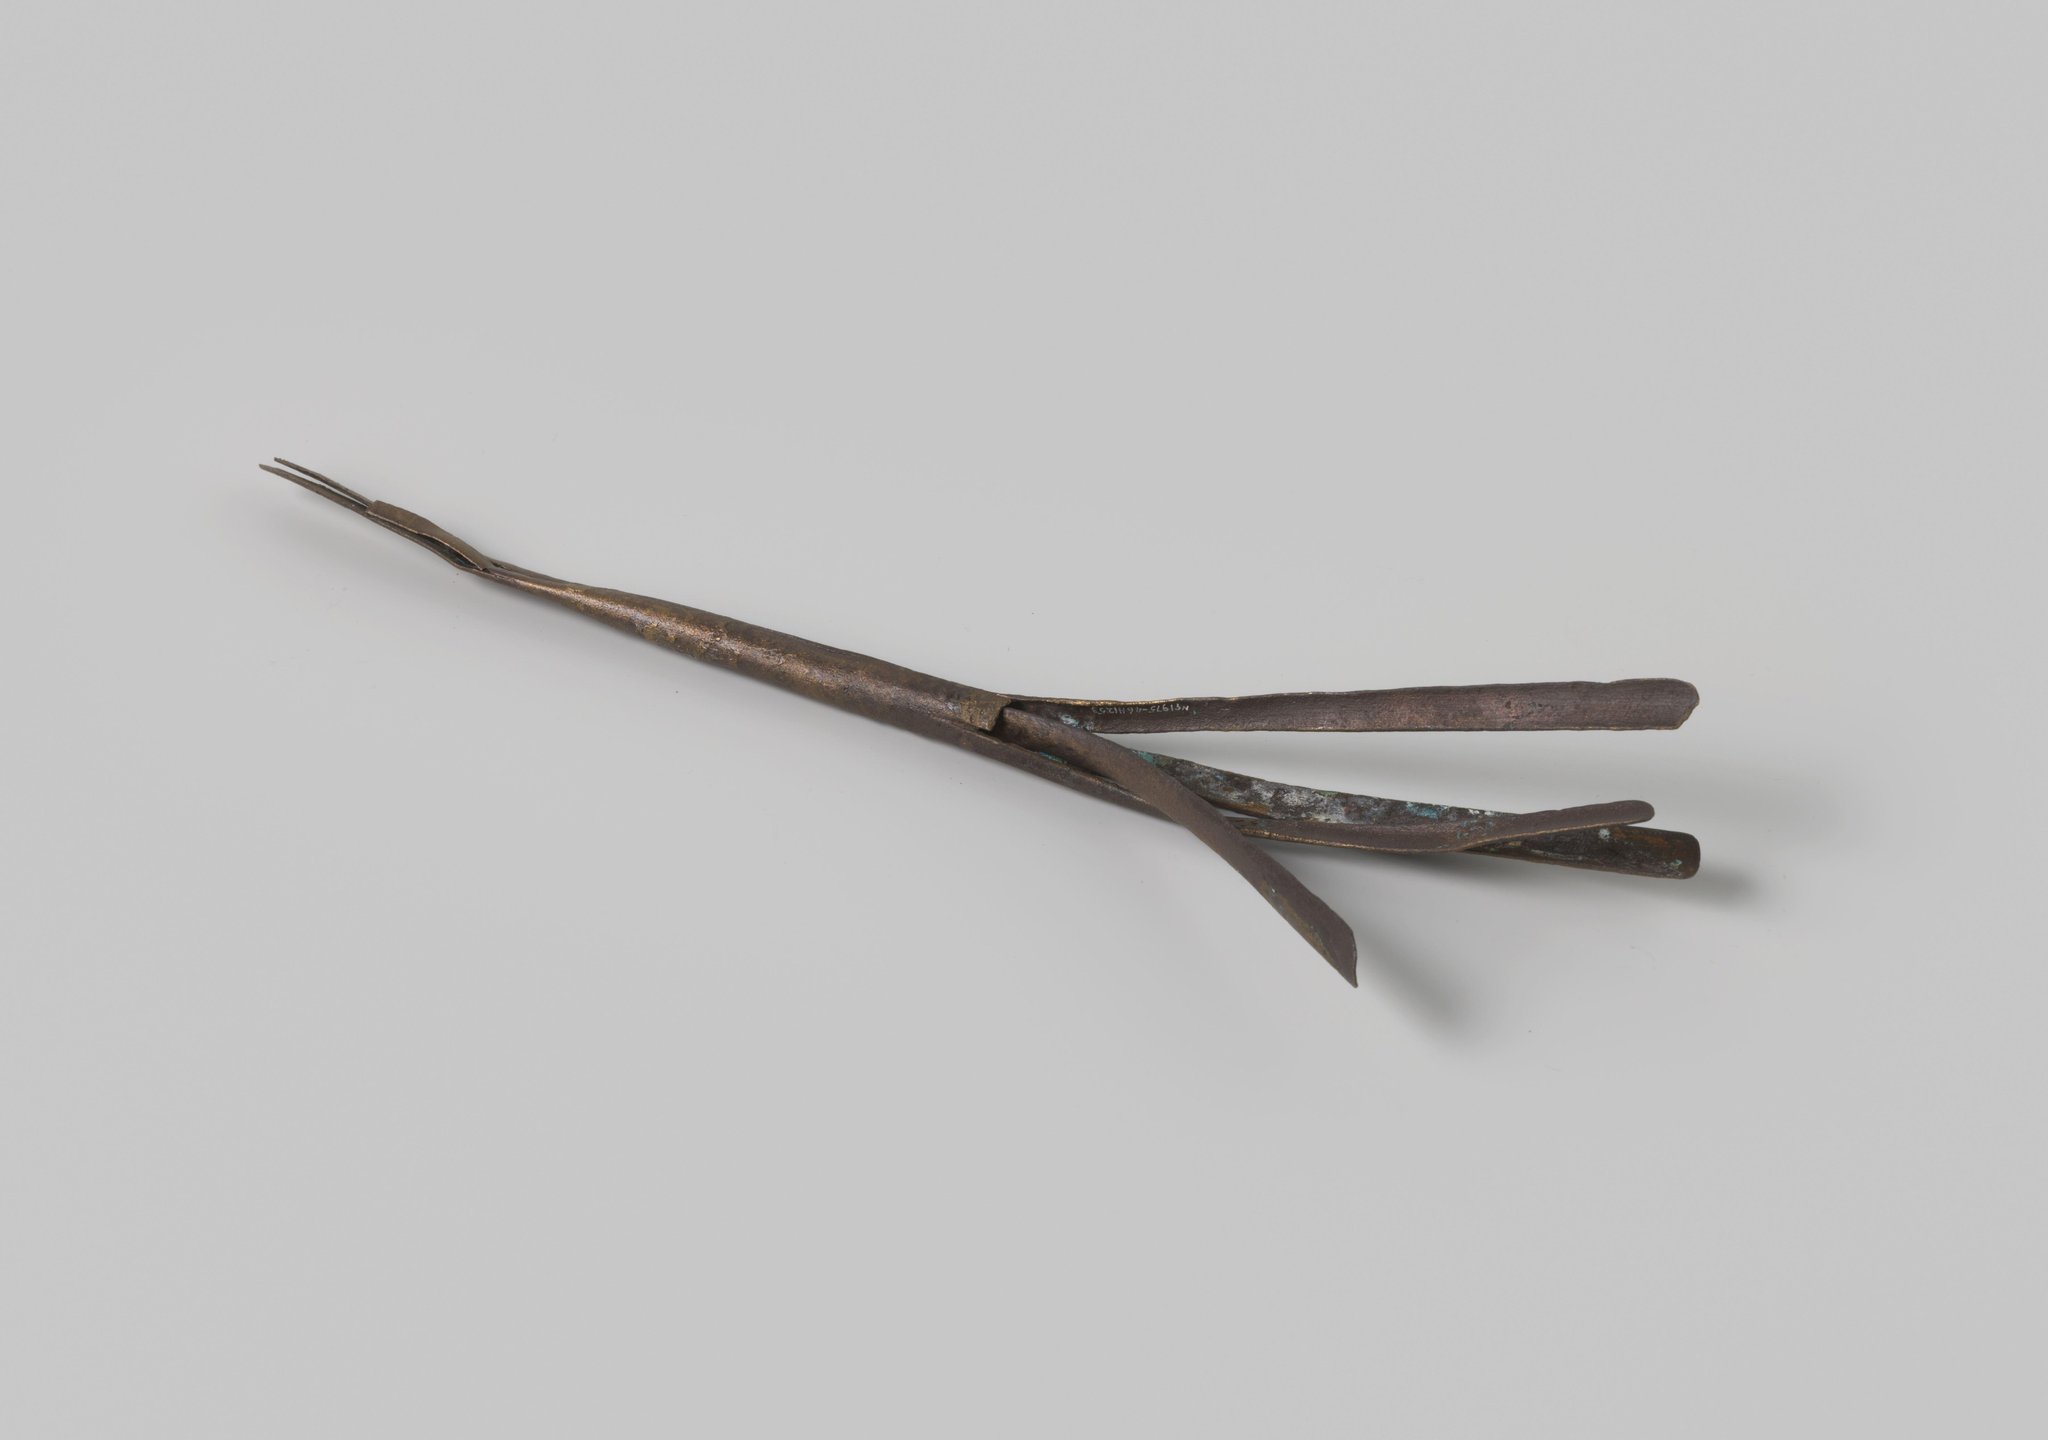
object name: needle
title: Naald uit het wrak van de Oost-Indiëvaarder Hollandia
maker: Anonymous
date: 1700-1743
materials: copper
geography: netherlands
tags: verenigde oostindische compagnie, hollandia (schip), annet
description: Tools and instruments, sewing and sailmaking, sailmaker's needle; sim. NG 1979-187H394 ending in 4 splayed strips. Pin.